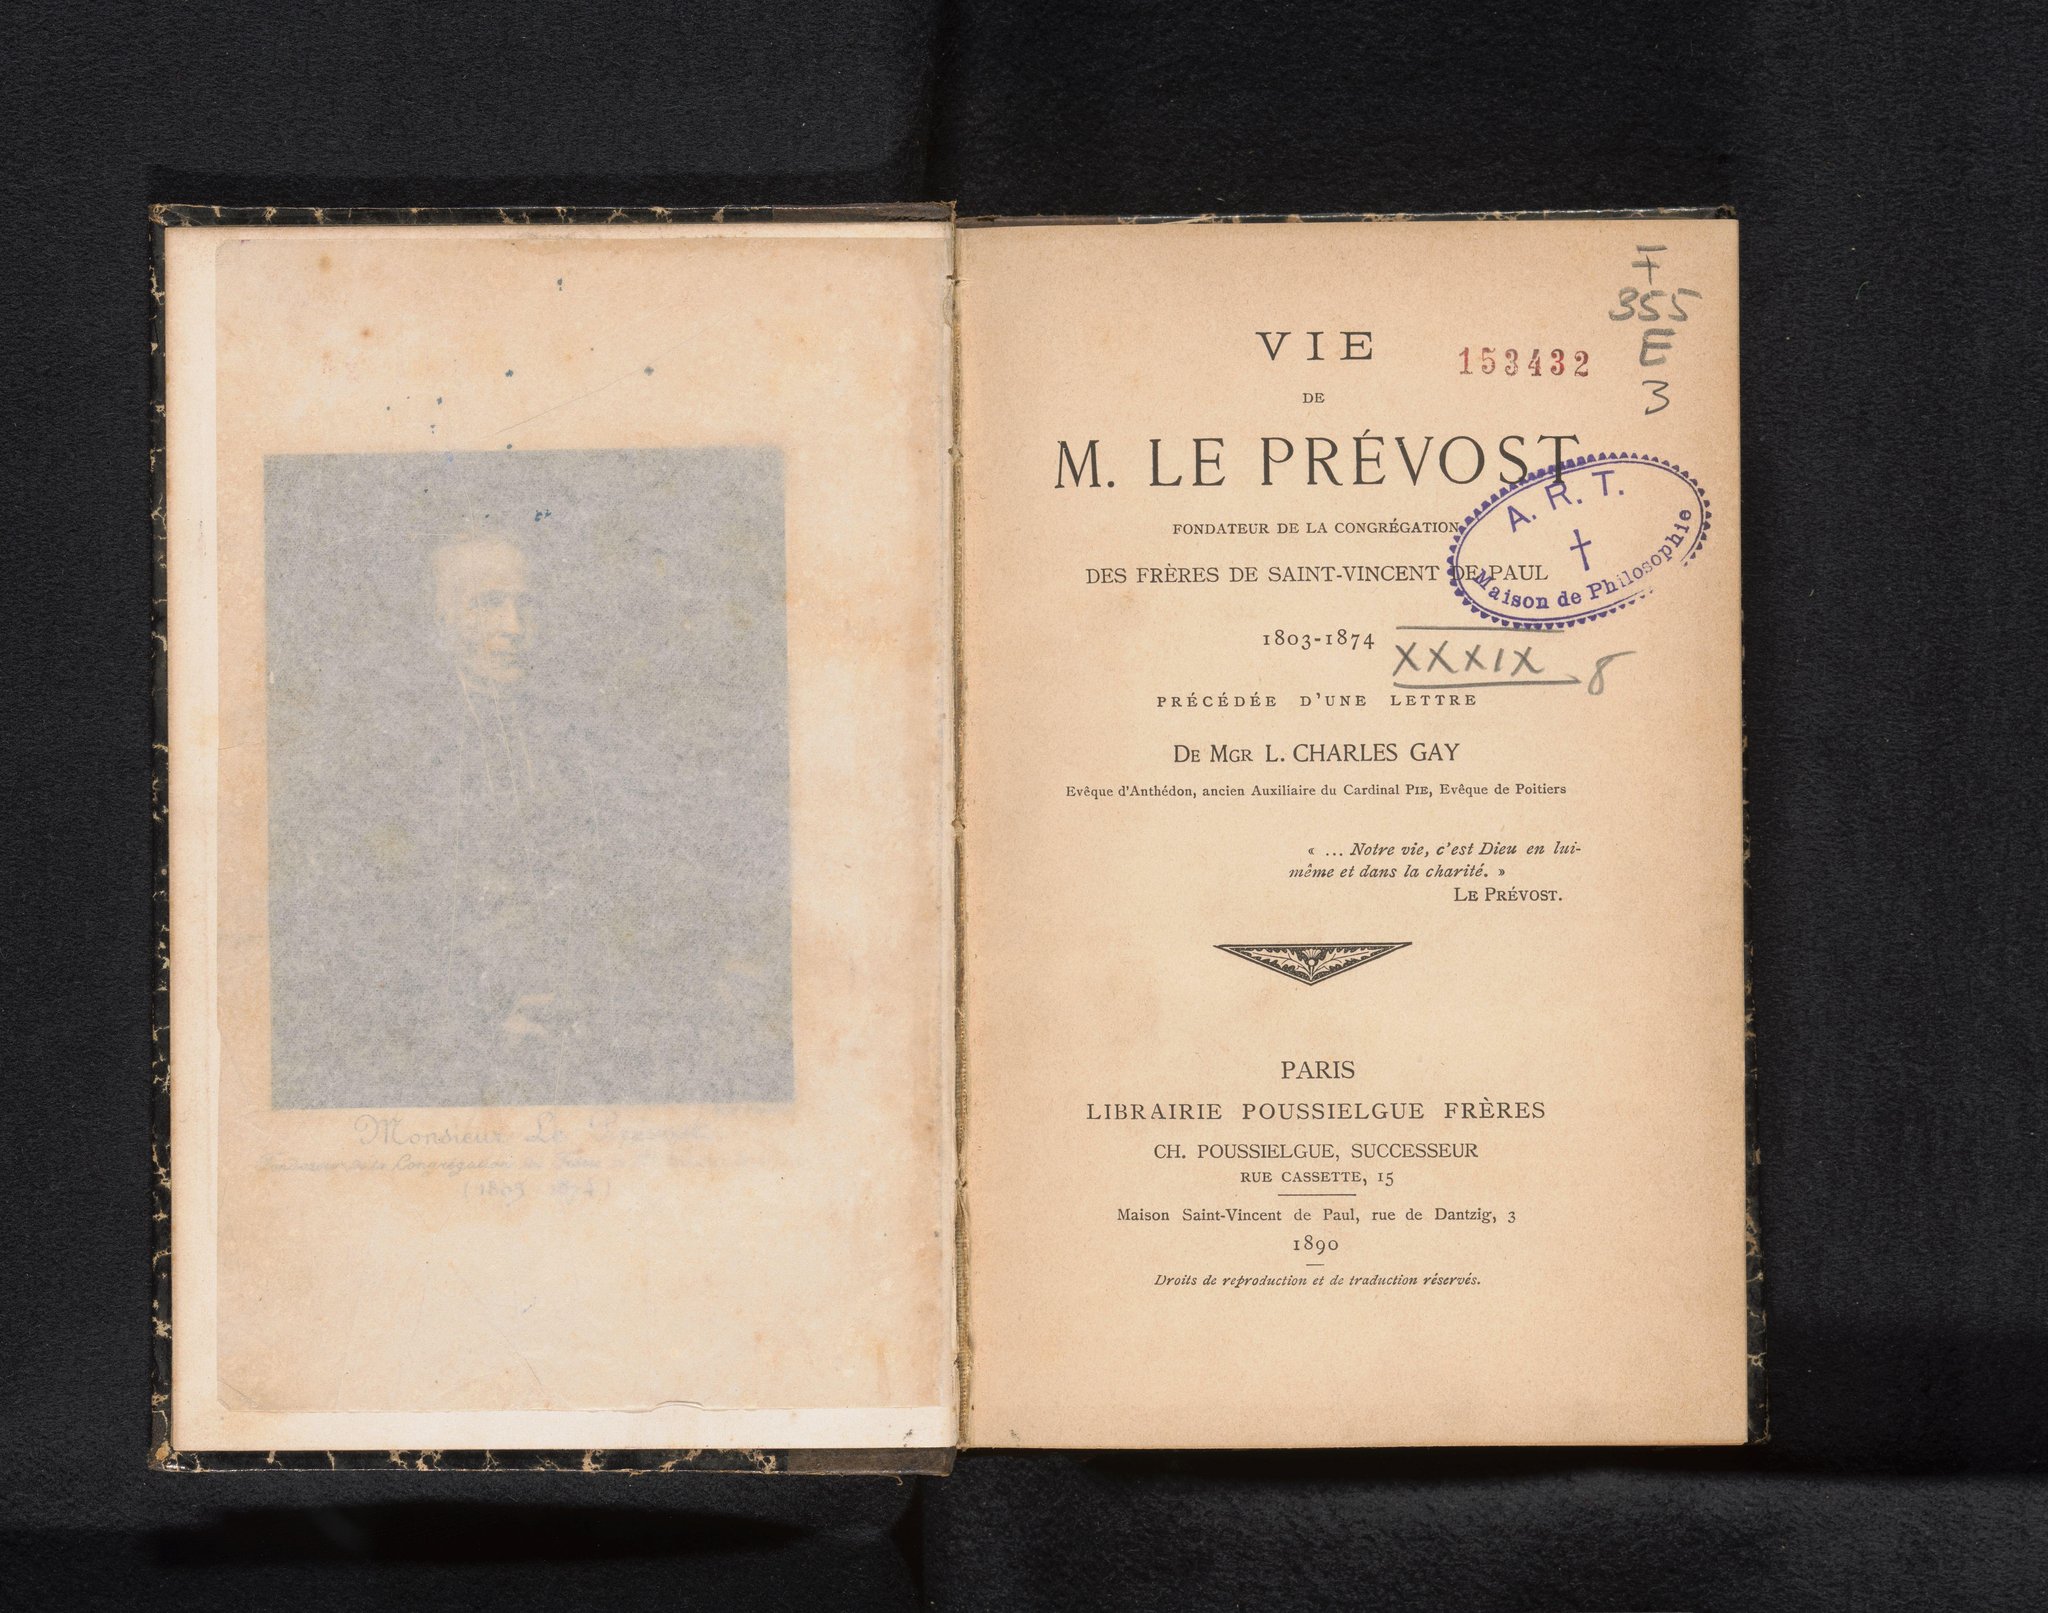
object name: book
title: La vie de M. le Prévost fondateur de la congrégation des Frères de Saint-Vincent de Paul 1803-1874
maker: charles gay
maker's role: clergyman, priest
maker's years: 1815-1892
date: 1890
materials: cardboard, leather, paper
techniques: marbled paper, photoaquatint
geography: paris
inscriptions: name: ‘Notre Ba[...] des Vocat[...]’, number: ‘153432’, name: ‘A.R.T. Maison de Philosophie’